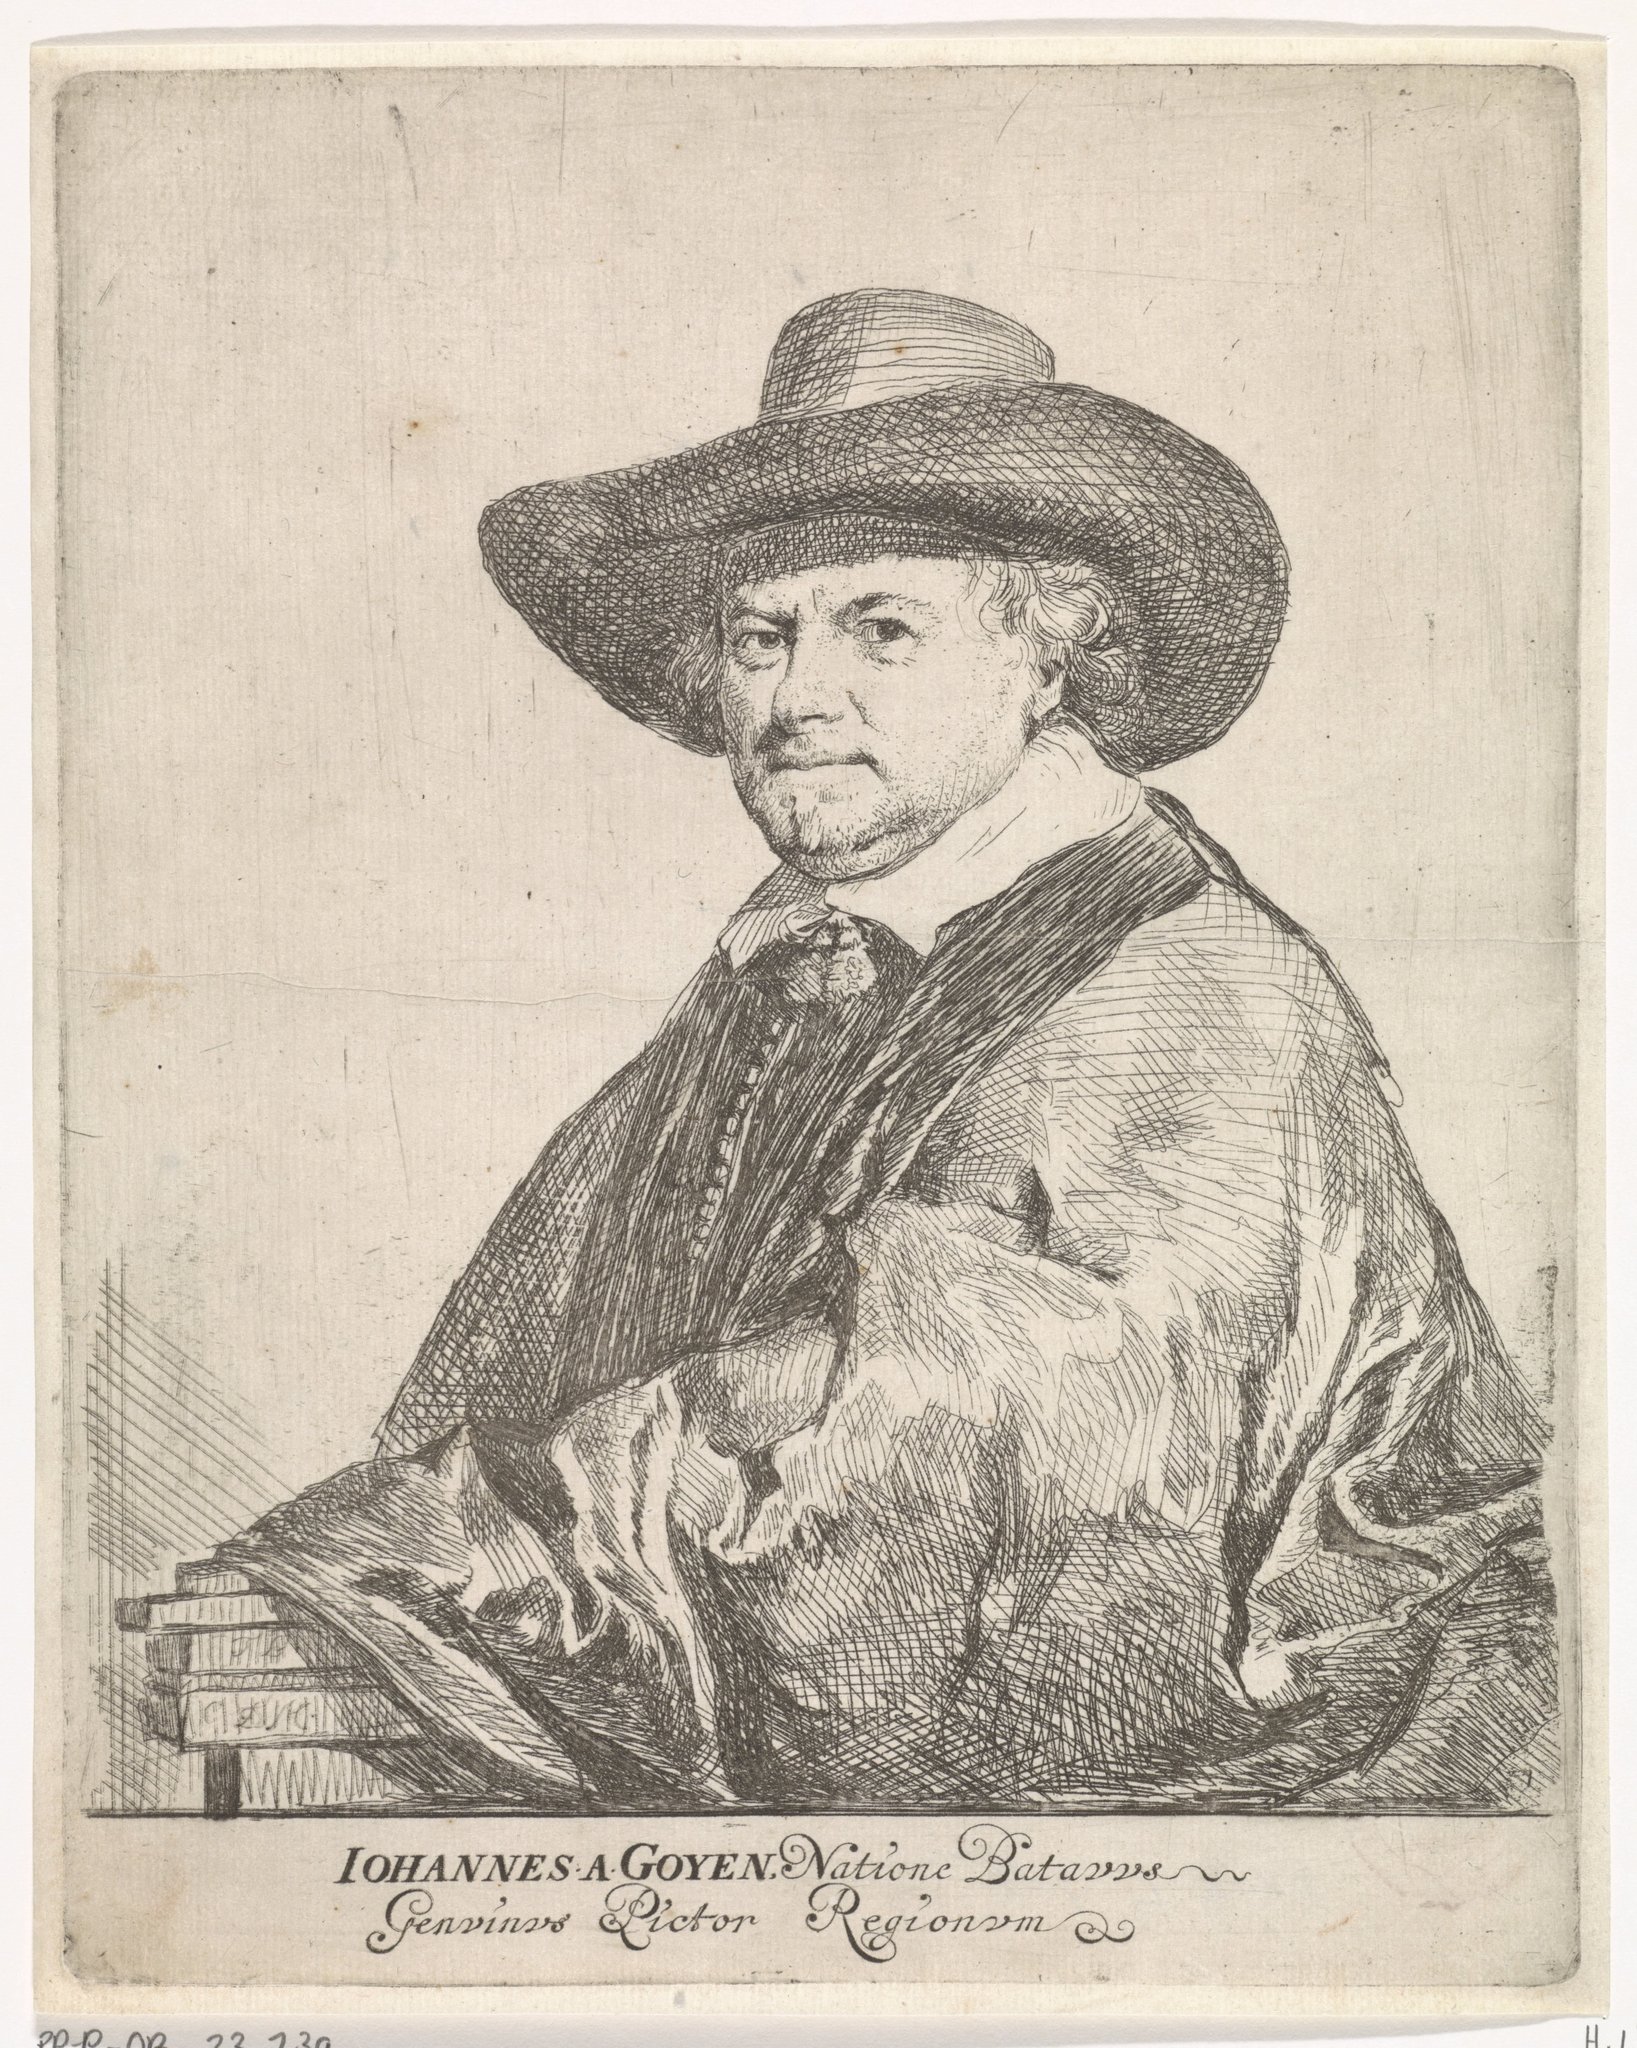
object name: print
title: Portret van Jan van Goyen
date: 1665-1738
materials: paper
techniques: etching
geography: netherlands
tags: the hague, painter, draughtsman, jan van goyen, portrait, self-portrait of painter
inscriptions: collector's mark: Lugt 240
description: Portret van de schilder Jan van Goyen, met een hoed op het hoofd, gekleed in mantel, bij een pilaar.